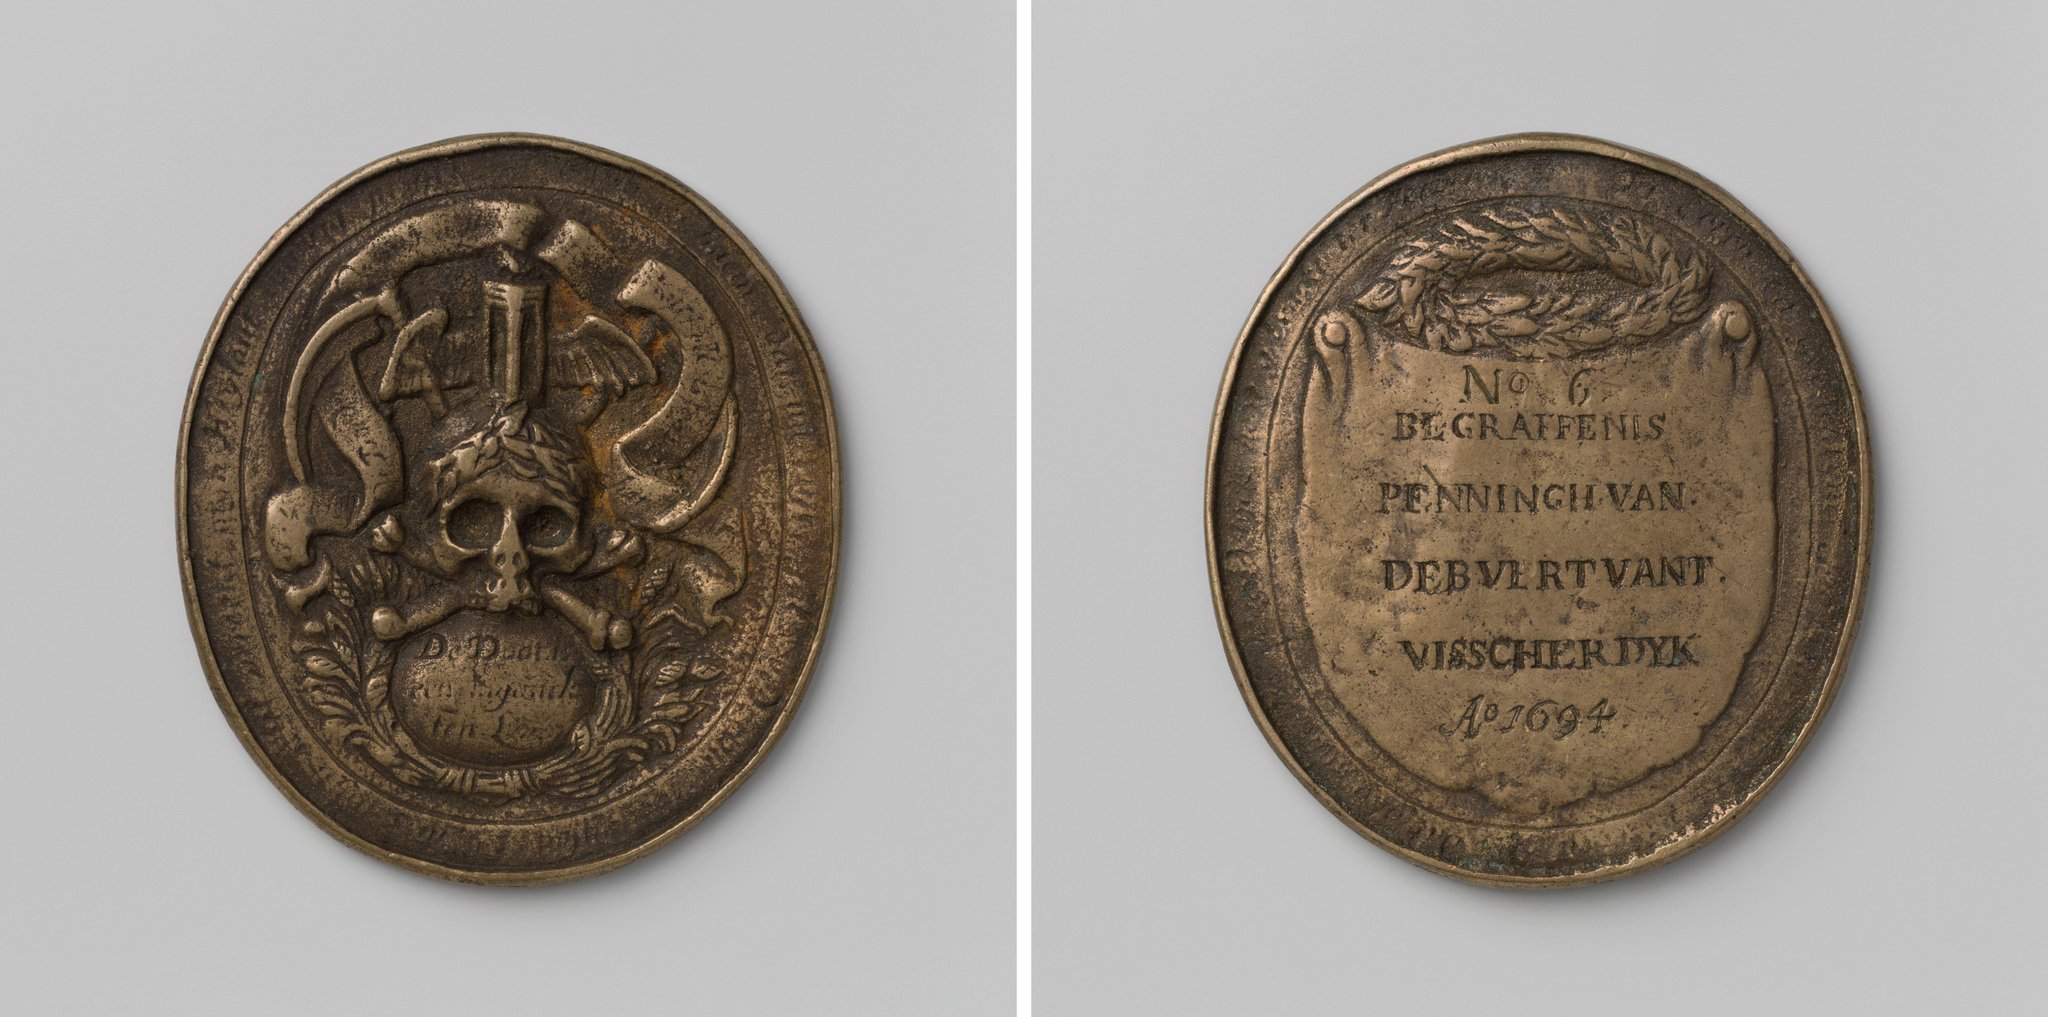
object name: buurtpenning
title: Buurt van de Visscherdijk te 's-Gravenhage, begrafenispenning met no. 6 vervaardigd uit overlijdenspenning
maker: Anonymous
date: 1694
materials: brass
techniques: casting, engraving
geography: the hague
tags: visscherdijk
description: Messing ovale penning. Voorzijde: gelauwerd doodshoofd op twee gekruiste beenderen boven cartouche met opschrift; daarboven gevleugelde zandloper en twee zeisen, waarom lint met opschrift is gedrapeerd binnen omschrift. Keerzijde: doek met opschrift onder lauwerkrans binnen omschrift. Opschriften beide zijden moeilijk leesbaar.